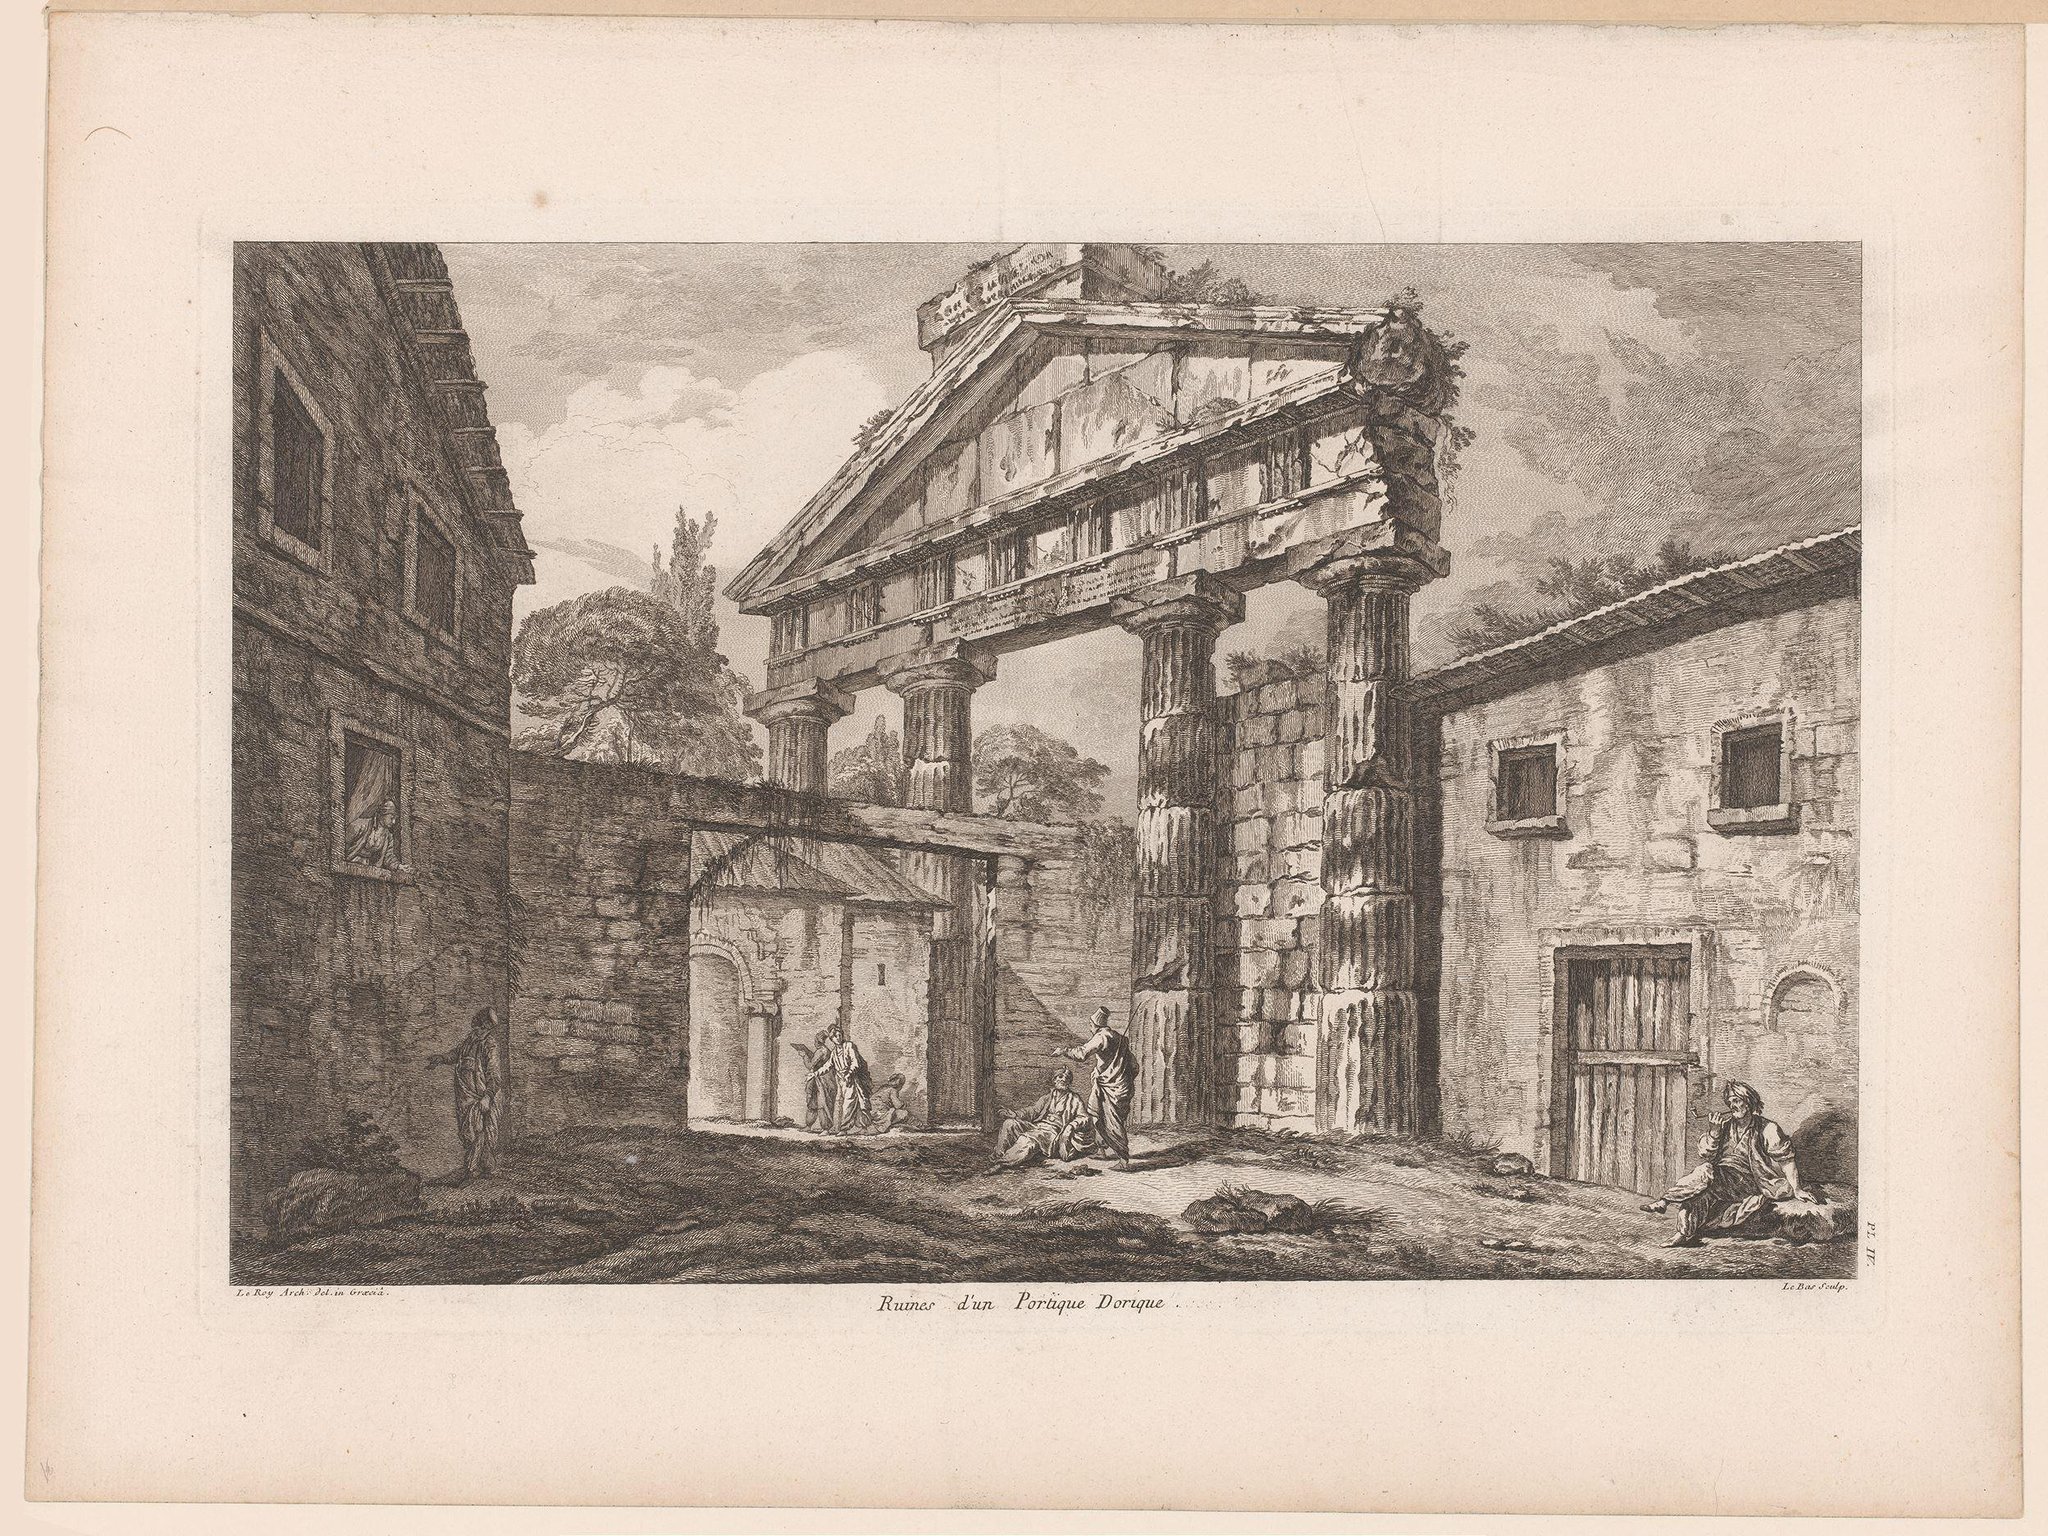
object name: book illustration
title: Ruines d'un Portique Dorique.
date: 1758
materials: paper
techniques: etching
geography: greece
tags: city-view in general; 'veduta', ruin of a building ~ architecture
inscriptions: collector's mark: Lugt 2760, collector's mark: Lugt 2228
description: Prent uit: Le Roy, Julien. Ruines des plus beaux monuments de la Grêce. Parijs: Guérin & de La Tour, 1758. Dit betreft plaat IV.